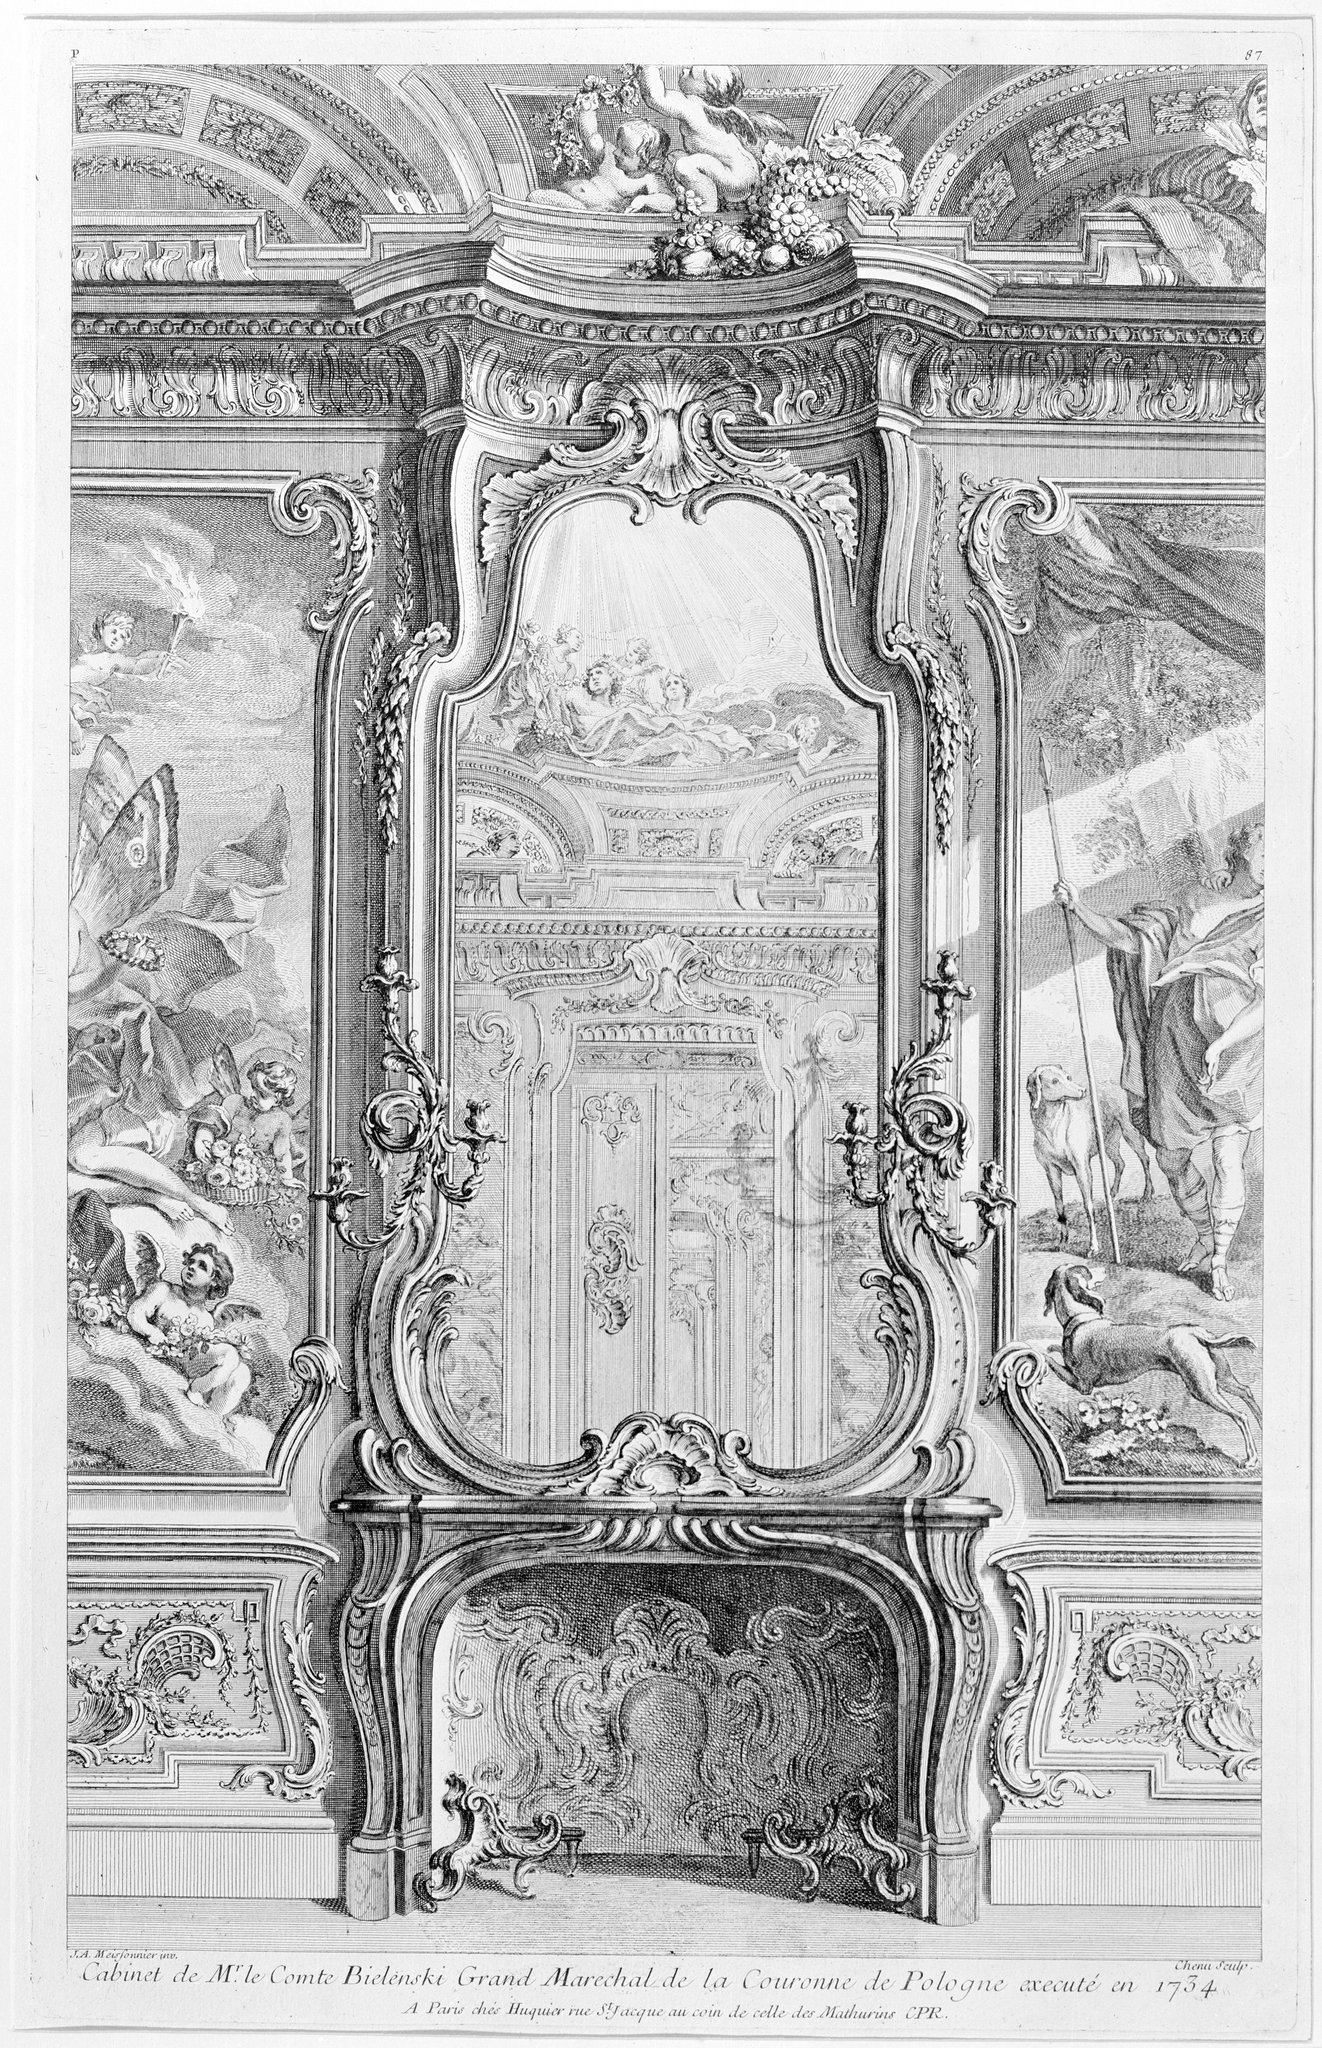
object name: book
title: Work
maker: juste aurèle meissonnier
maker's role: artist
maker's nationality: french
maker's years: 1695-1750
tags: fireplaces,dogs,mirrors